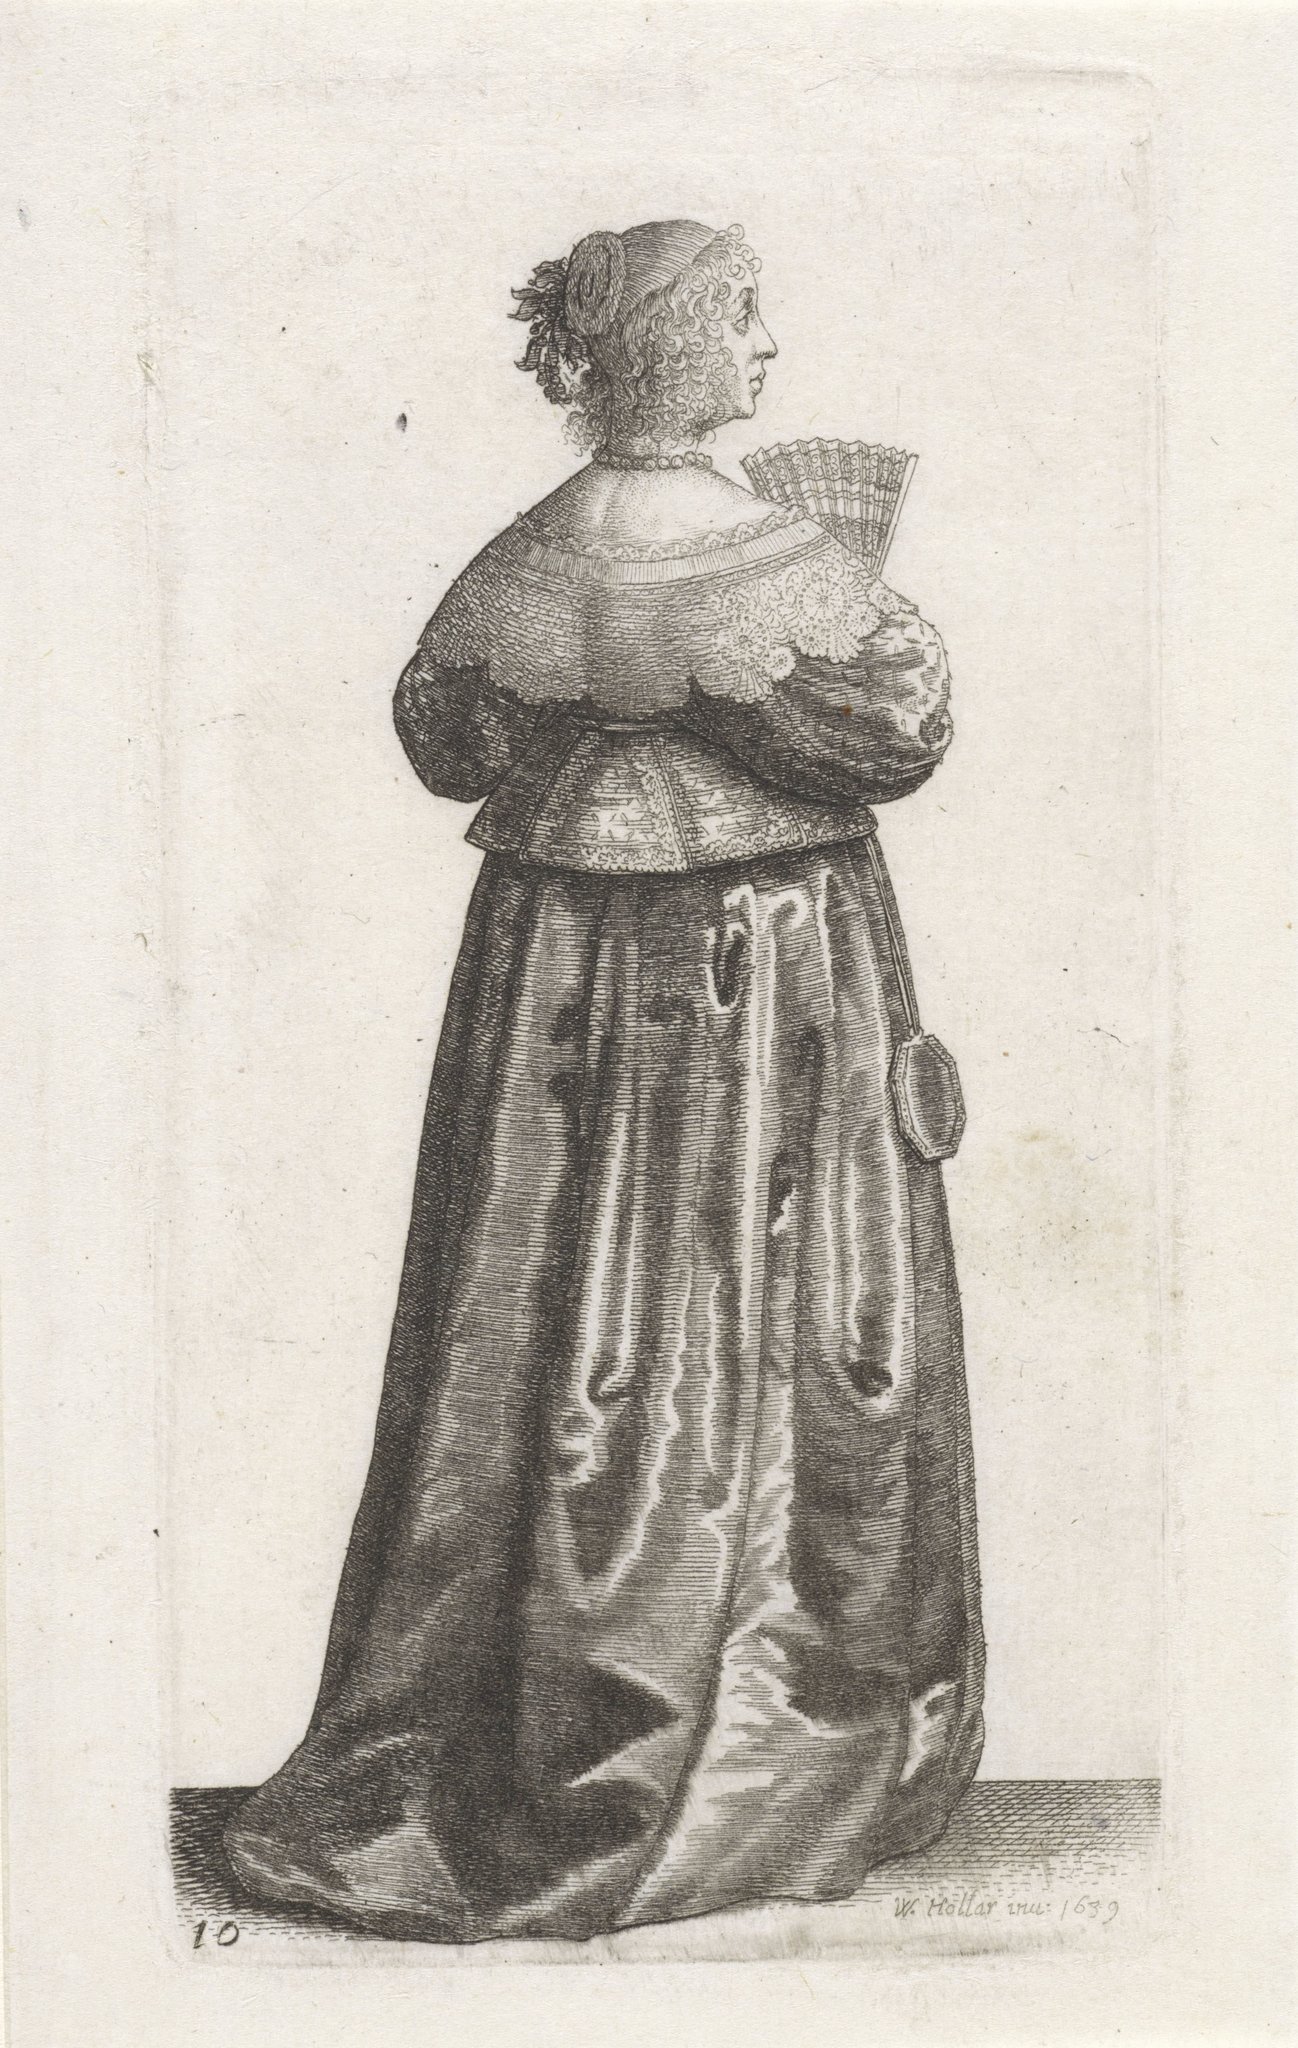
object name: costume print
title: Ornatus Muliebris Anglicanus (The Clothing of English Women)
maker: wenceslaus hollar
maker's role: draughtsman, print maker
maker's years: 1607-1677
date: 1639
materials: paper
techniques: etching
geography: london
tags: europeans: englishmen (+ women), other clothing accessories (mirror) (+ women's clothes), styles of hairdress - aa - ~ women, mirror - aa - (for) women, neck-gear: collar (+ women's clothes), skirt (+ women's clothes), dress, gown (+ women's clothes), necklace (+ women's clothes), clothing for the upper part of the body (with name) (+ women's clothes), belt, girdle, waistband (+ women's clothes), england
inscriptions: collector's mark: Lugt 654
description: The diversity of women’s apparel in England is illustrated in this extensive costume series. Hollar represented women from all ranks of society, from the humble countrywoman 1 to the elegant noblewoman 2. The more fashionable costumes are based on eyewitness observation of the ladies at the court of the Earl of Arundel, Hollar’s primary patron. They are therefore among the more reliable visual sources for costume historians.